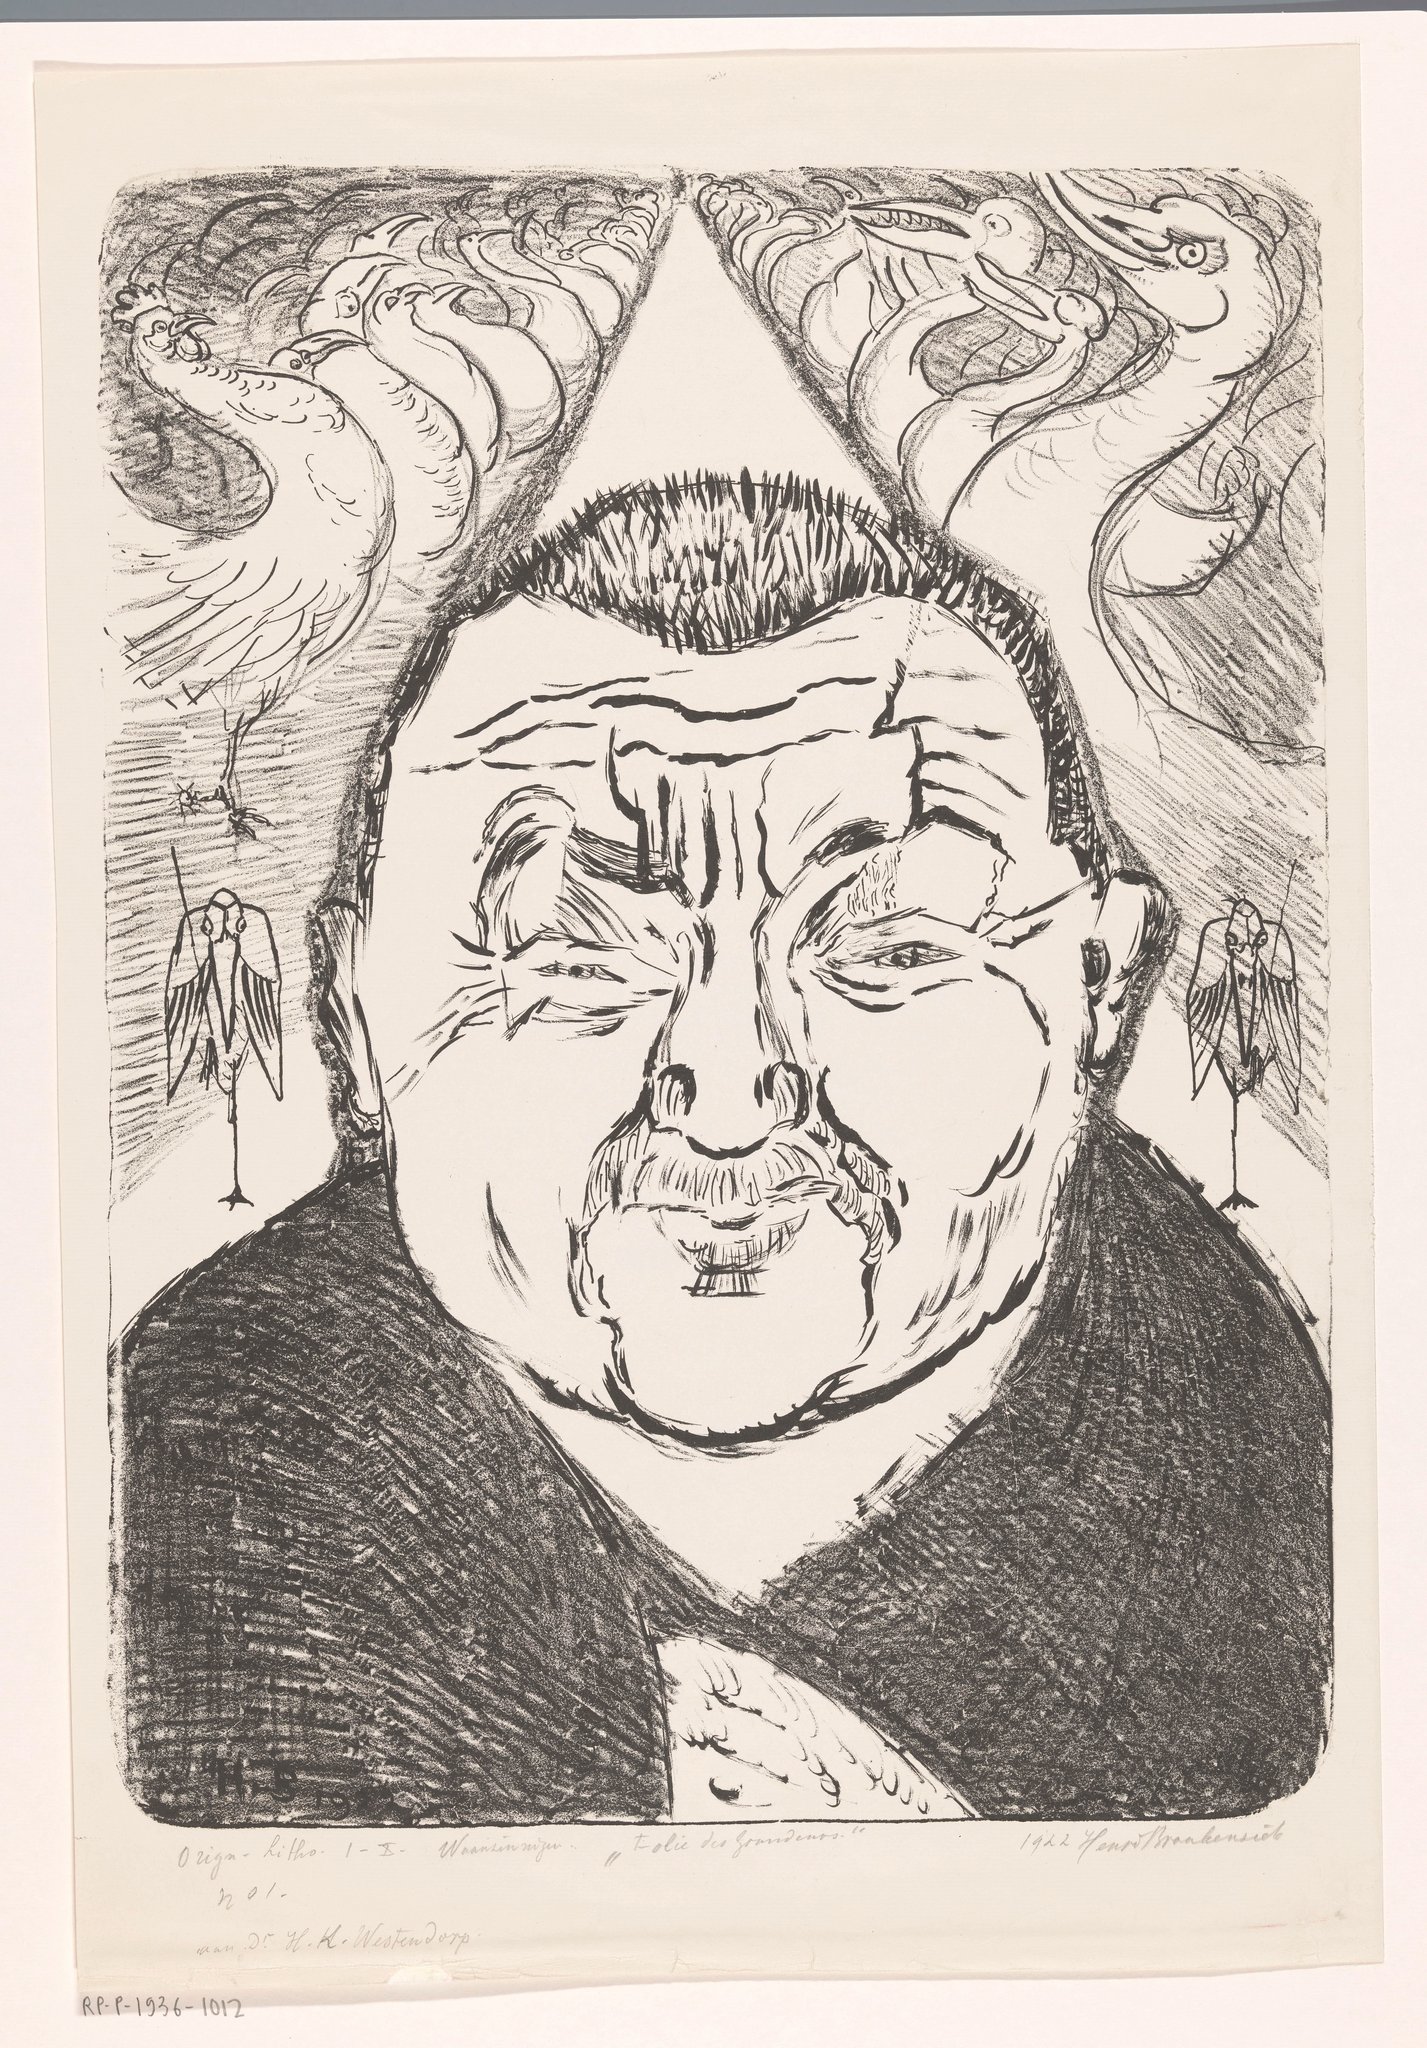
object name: print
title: Waanzinnigen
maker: henri braakensiek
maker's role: print maker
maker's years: 1891-1941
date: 1922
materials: paper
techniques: lithograph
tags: arrogance; 'arroganza' (ripa), caricatures (human types), birds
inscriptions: inscription: ‘aan Dr. H.K. Westendorp’, collector's mark: Lugt 2228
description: Portret van een man met snor. Aan weerszijden van zijn hoofd een vogel die op één been staat. Zowel links- als rechtsboven verschillende vogels staand in rijen.